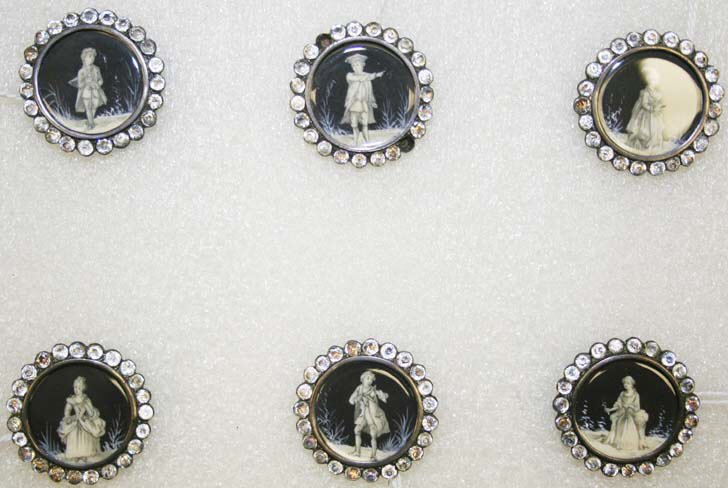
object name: button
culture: french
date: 1770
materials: glass, ivory, metal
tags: men,women